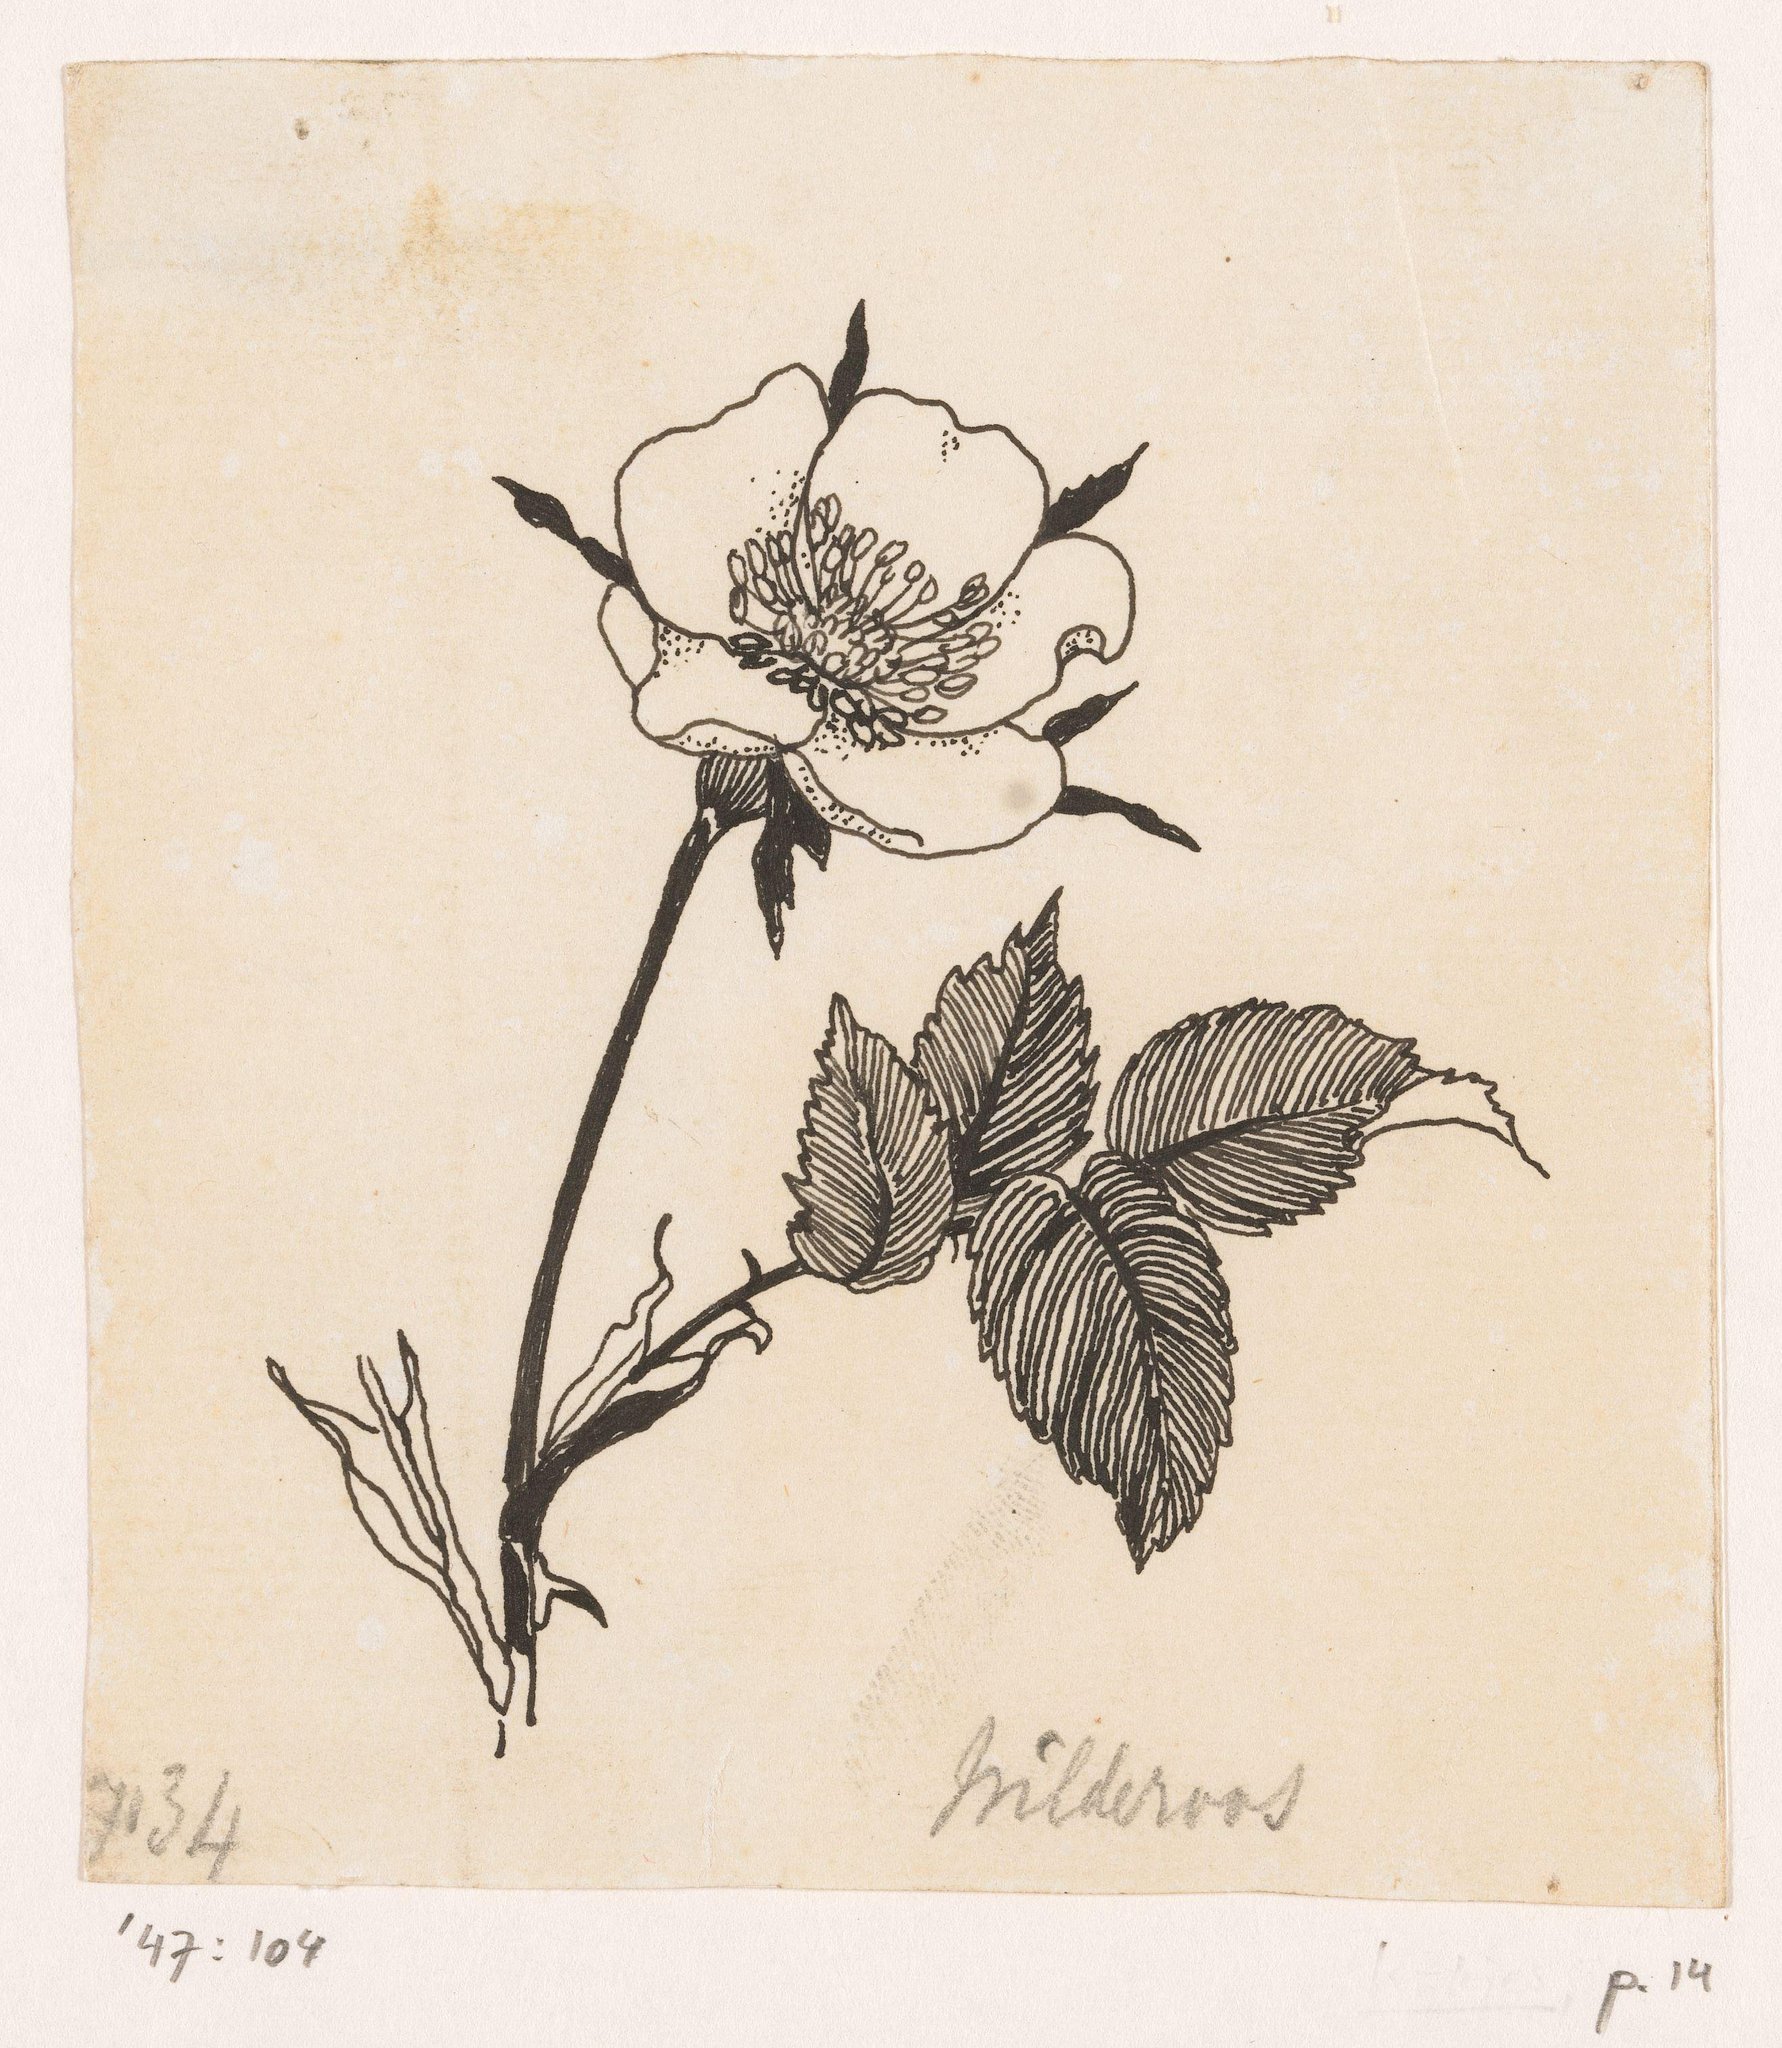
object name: drawing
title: Wilde roos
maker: willem wenckebach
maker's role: designer, draughtsman, painter, print maker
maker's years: 1860-1937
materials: ink, paper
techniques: pen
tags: flowers: rose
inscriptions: collector's mark: Lugt 2228a, : ‘verkleinen’, annotation: ‘wilderoos’, number: ‘7134’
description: Ontwerp voor: Knappert, Emilie C. Kijkjes in de plantenwereld. Loman & Funke: Amsterdam, 1893.